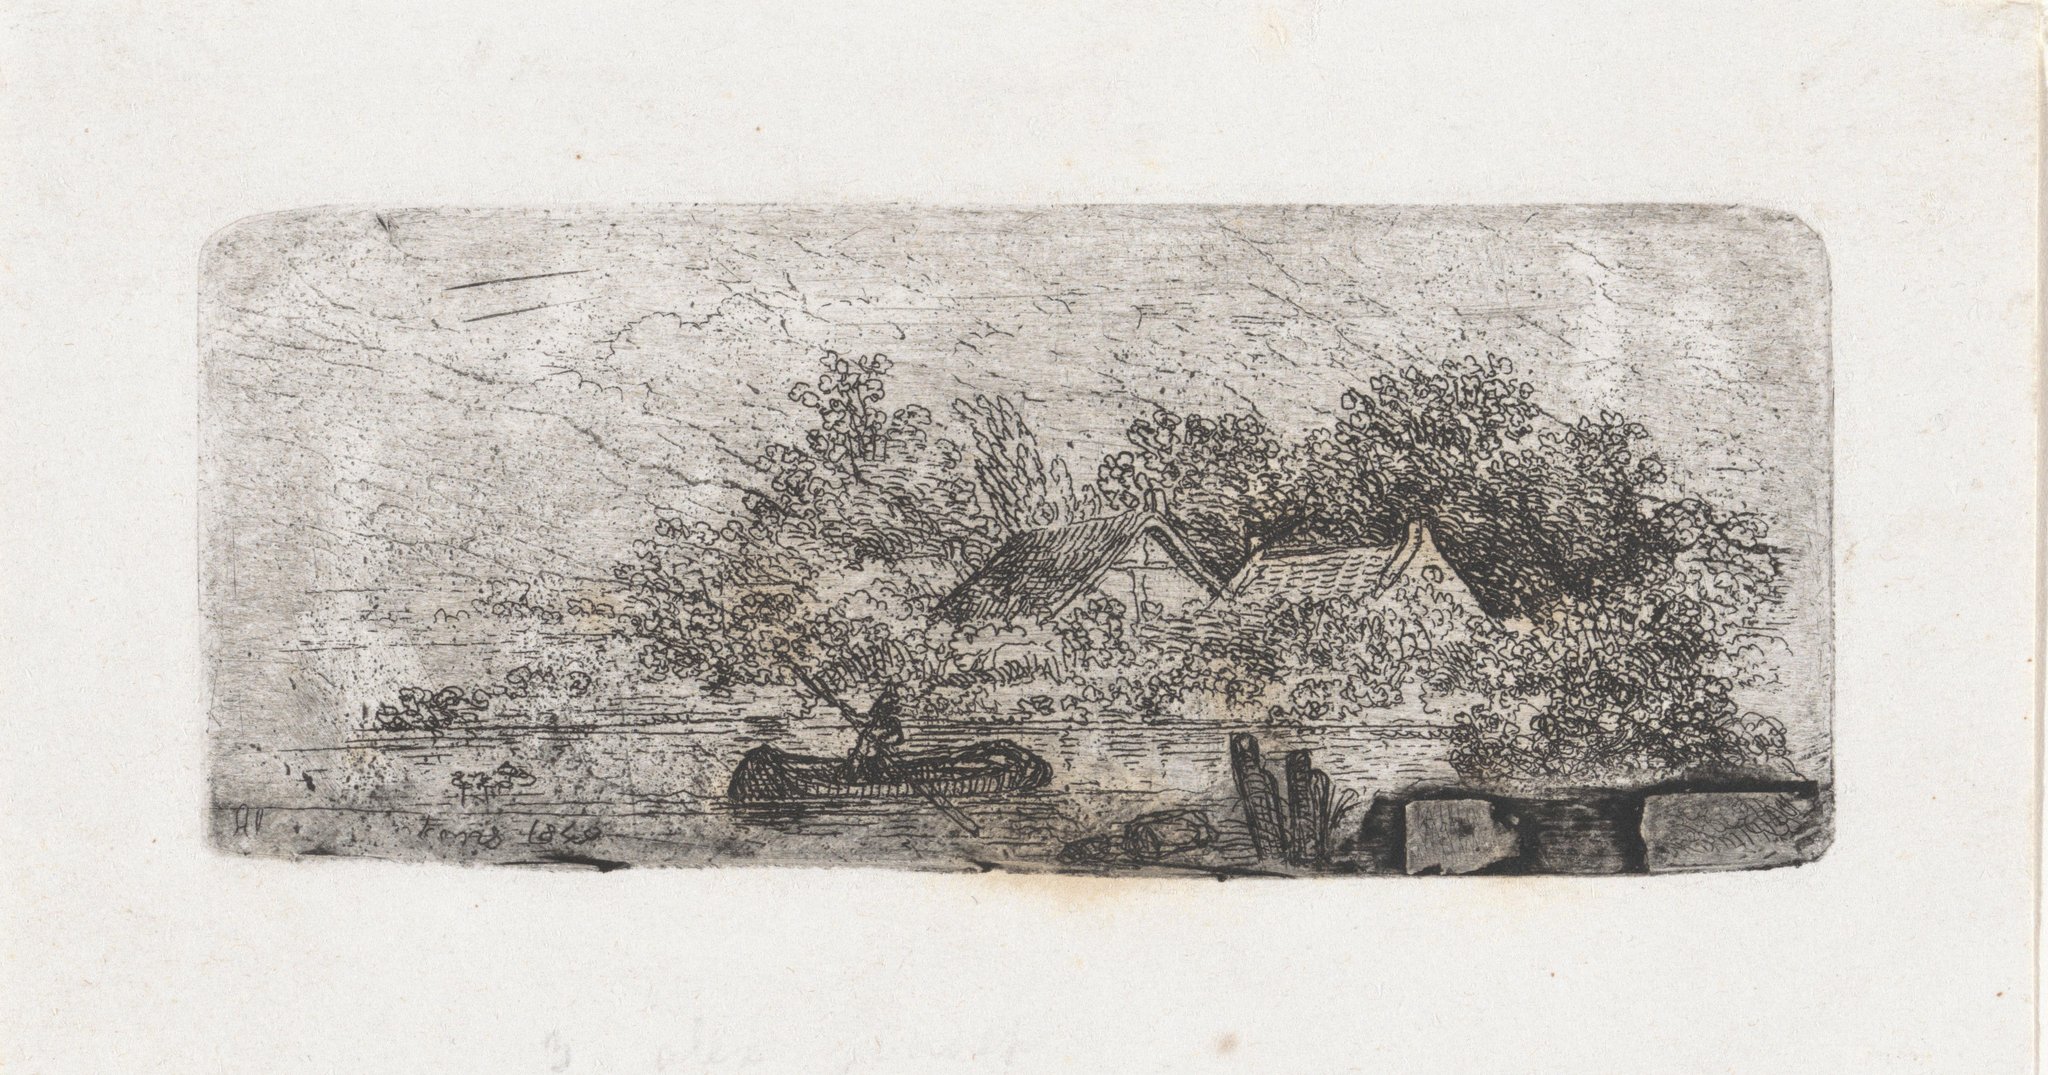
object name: print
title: Twee boerderijen aan het water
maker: alexander schaepkens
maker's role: draughtsman, print maker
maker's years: 1815-1899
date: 1849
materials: paper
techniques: etching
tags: landscapes with waters, waterscapes, seascapes (in the temperate zone), farm or solitary house in landscape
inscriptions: collector's mark: Lugt 1485, collector's mark: Lugt 2228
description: Ets gebundeld in de serie Près de la Meuse, 11 Eaux-Fortes par Alex. Schaepkens (1855 of later).